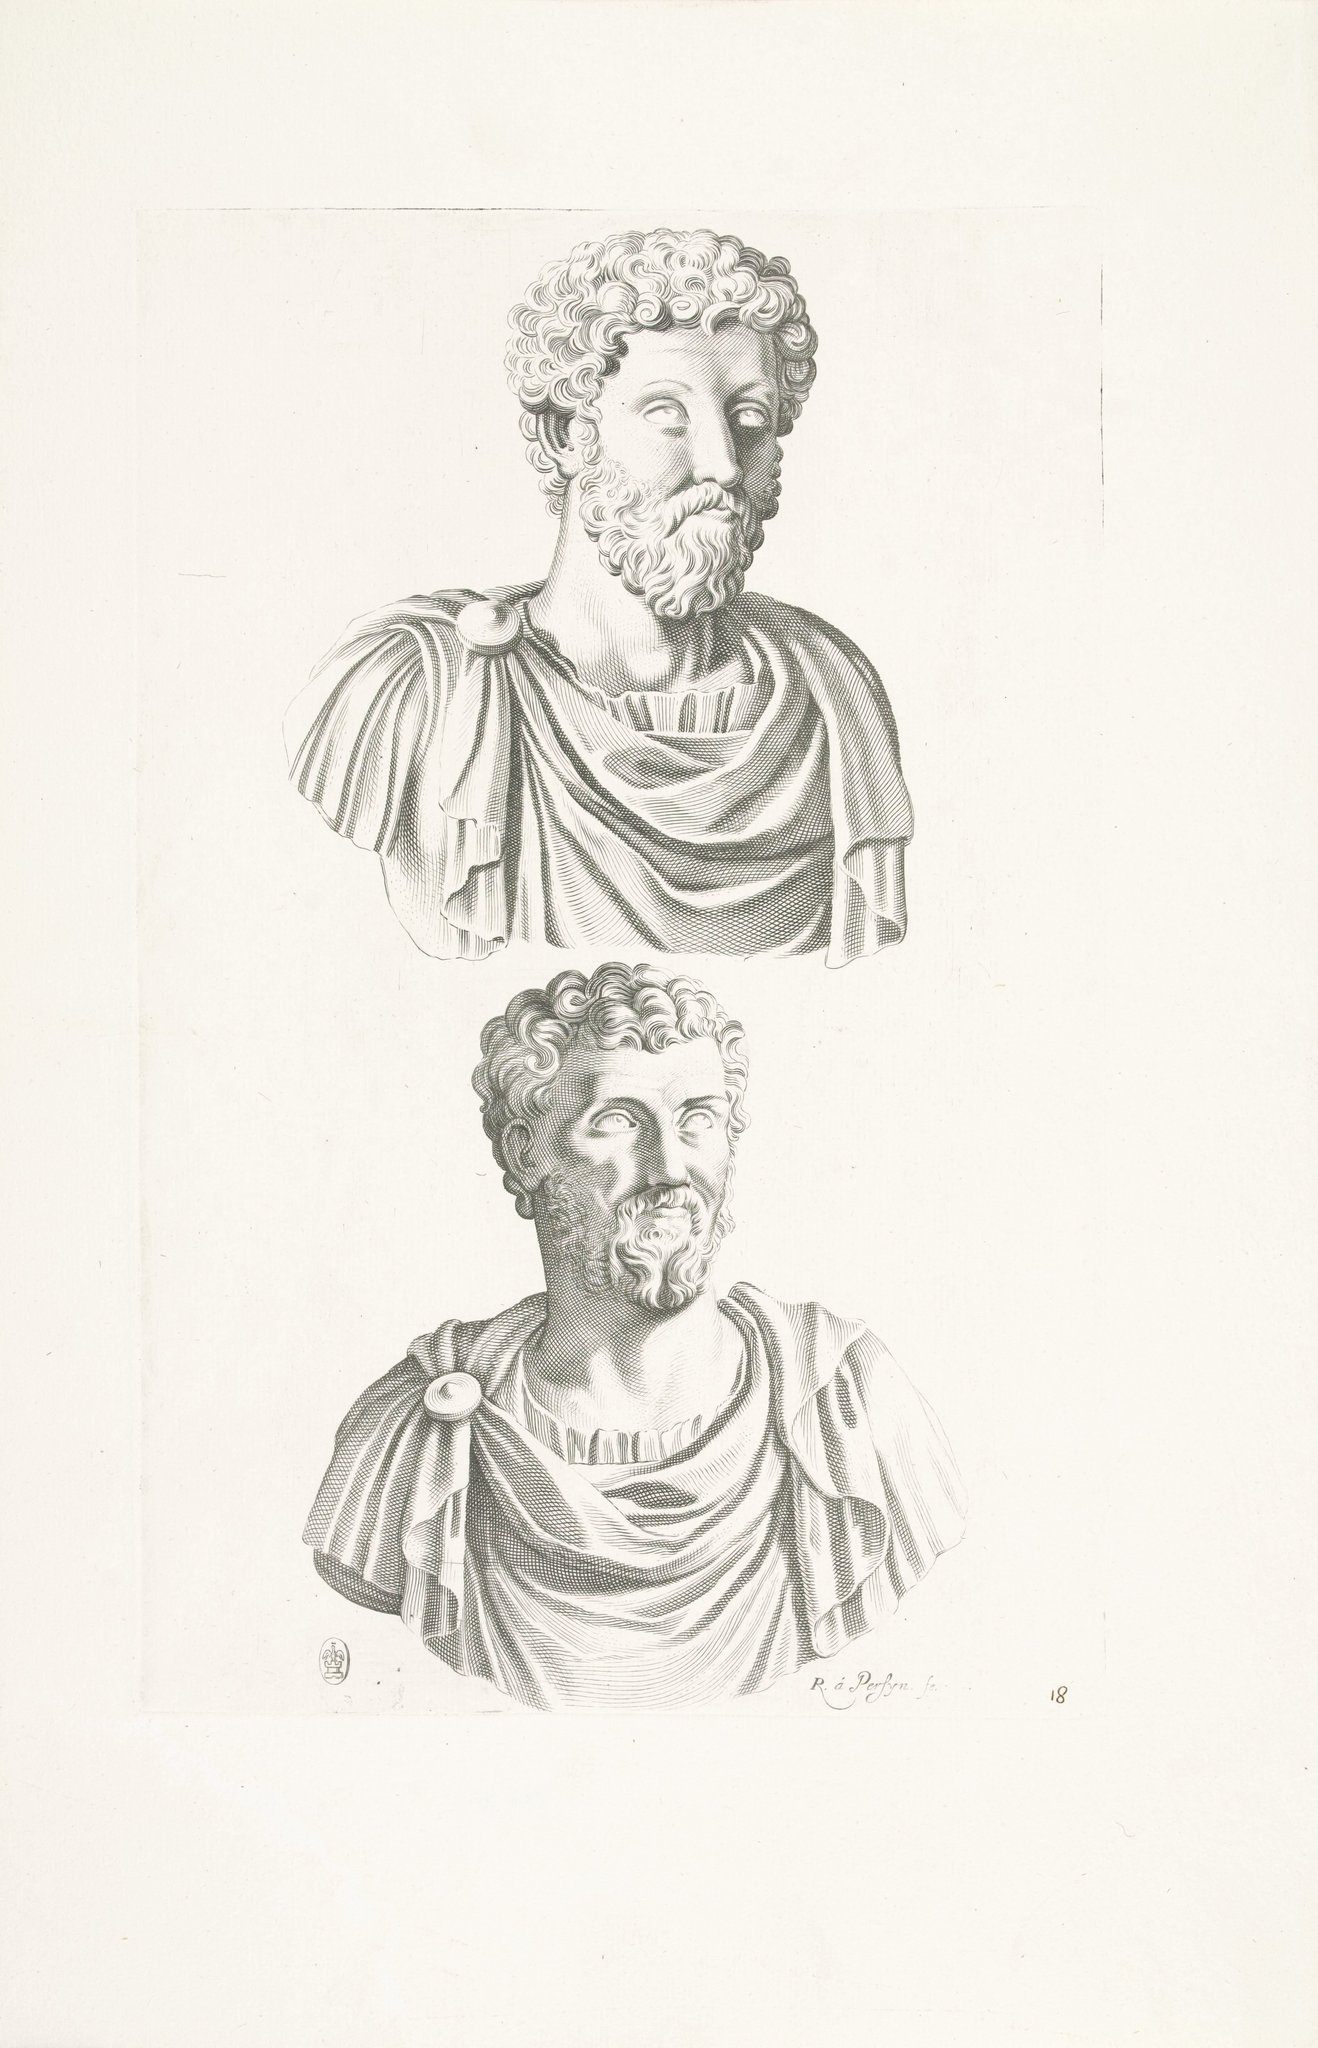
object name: print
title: Galleria Giustiniana del Marchese Vincenzo Giustiniani II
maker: reinier van persijn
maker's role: draughtsman, painter, print maker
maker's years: 1614-1668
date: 1640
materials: paper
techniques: engraving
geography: rome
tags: vincenzo giustiniani (1564-1637), piece of sculpture, reproduction of a piece of sculpture, beard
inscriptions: collector's mark: Lugt 2228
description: Twee Romeinse portretbustes van keizer Marcus Aurelius en keizer Septimius Severus. Zij dragen een toga. Linksonder het wapenschild van Vincenzo Giustiniani. Prent uit een publicatie met reproductieprenten naar de sculpturen in de verzameling in de Galleria Giustiniani te Rome.